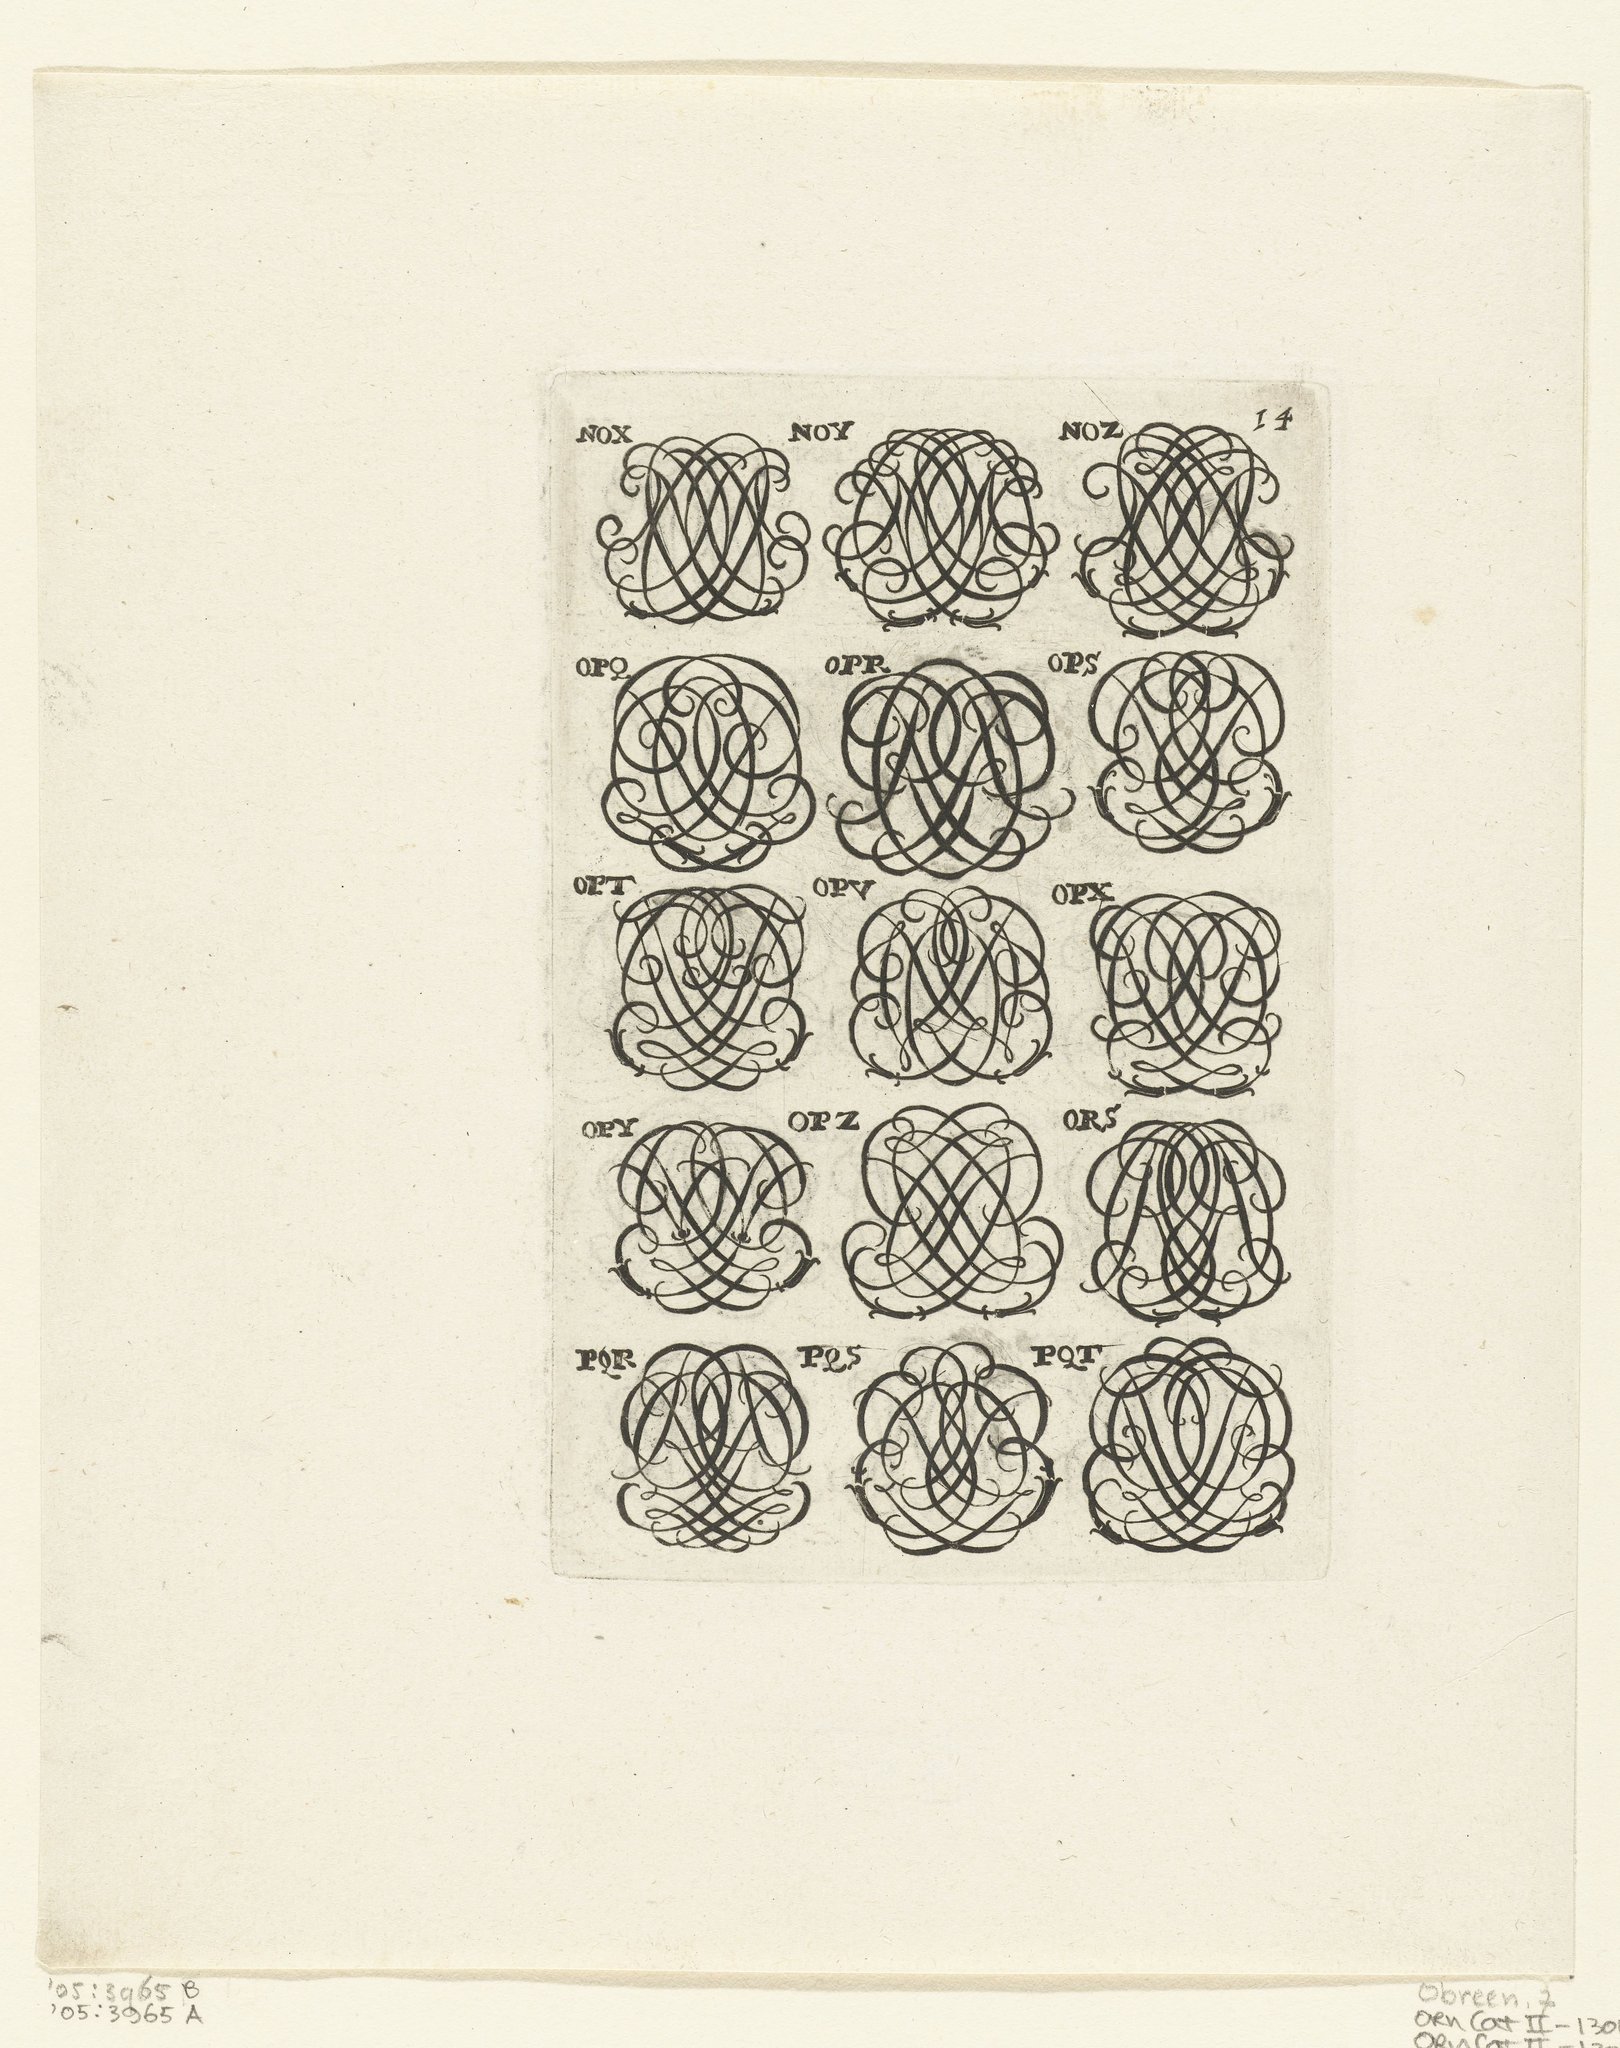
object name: ornament print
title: Livre nouveau et utile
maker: daniel de lafeuille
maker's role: print maker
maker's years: 1640-1709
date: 1690-1691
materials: paper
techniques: engraving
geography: amsterdam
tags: letters, alphabet, script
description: Uit serie van 29 deels genummerde bladen met cijfermonogrammen.